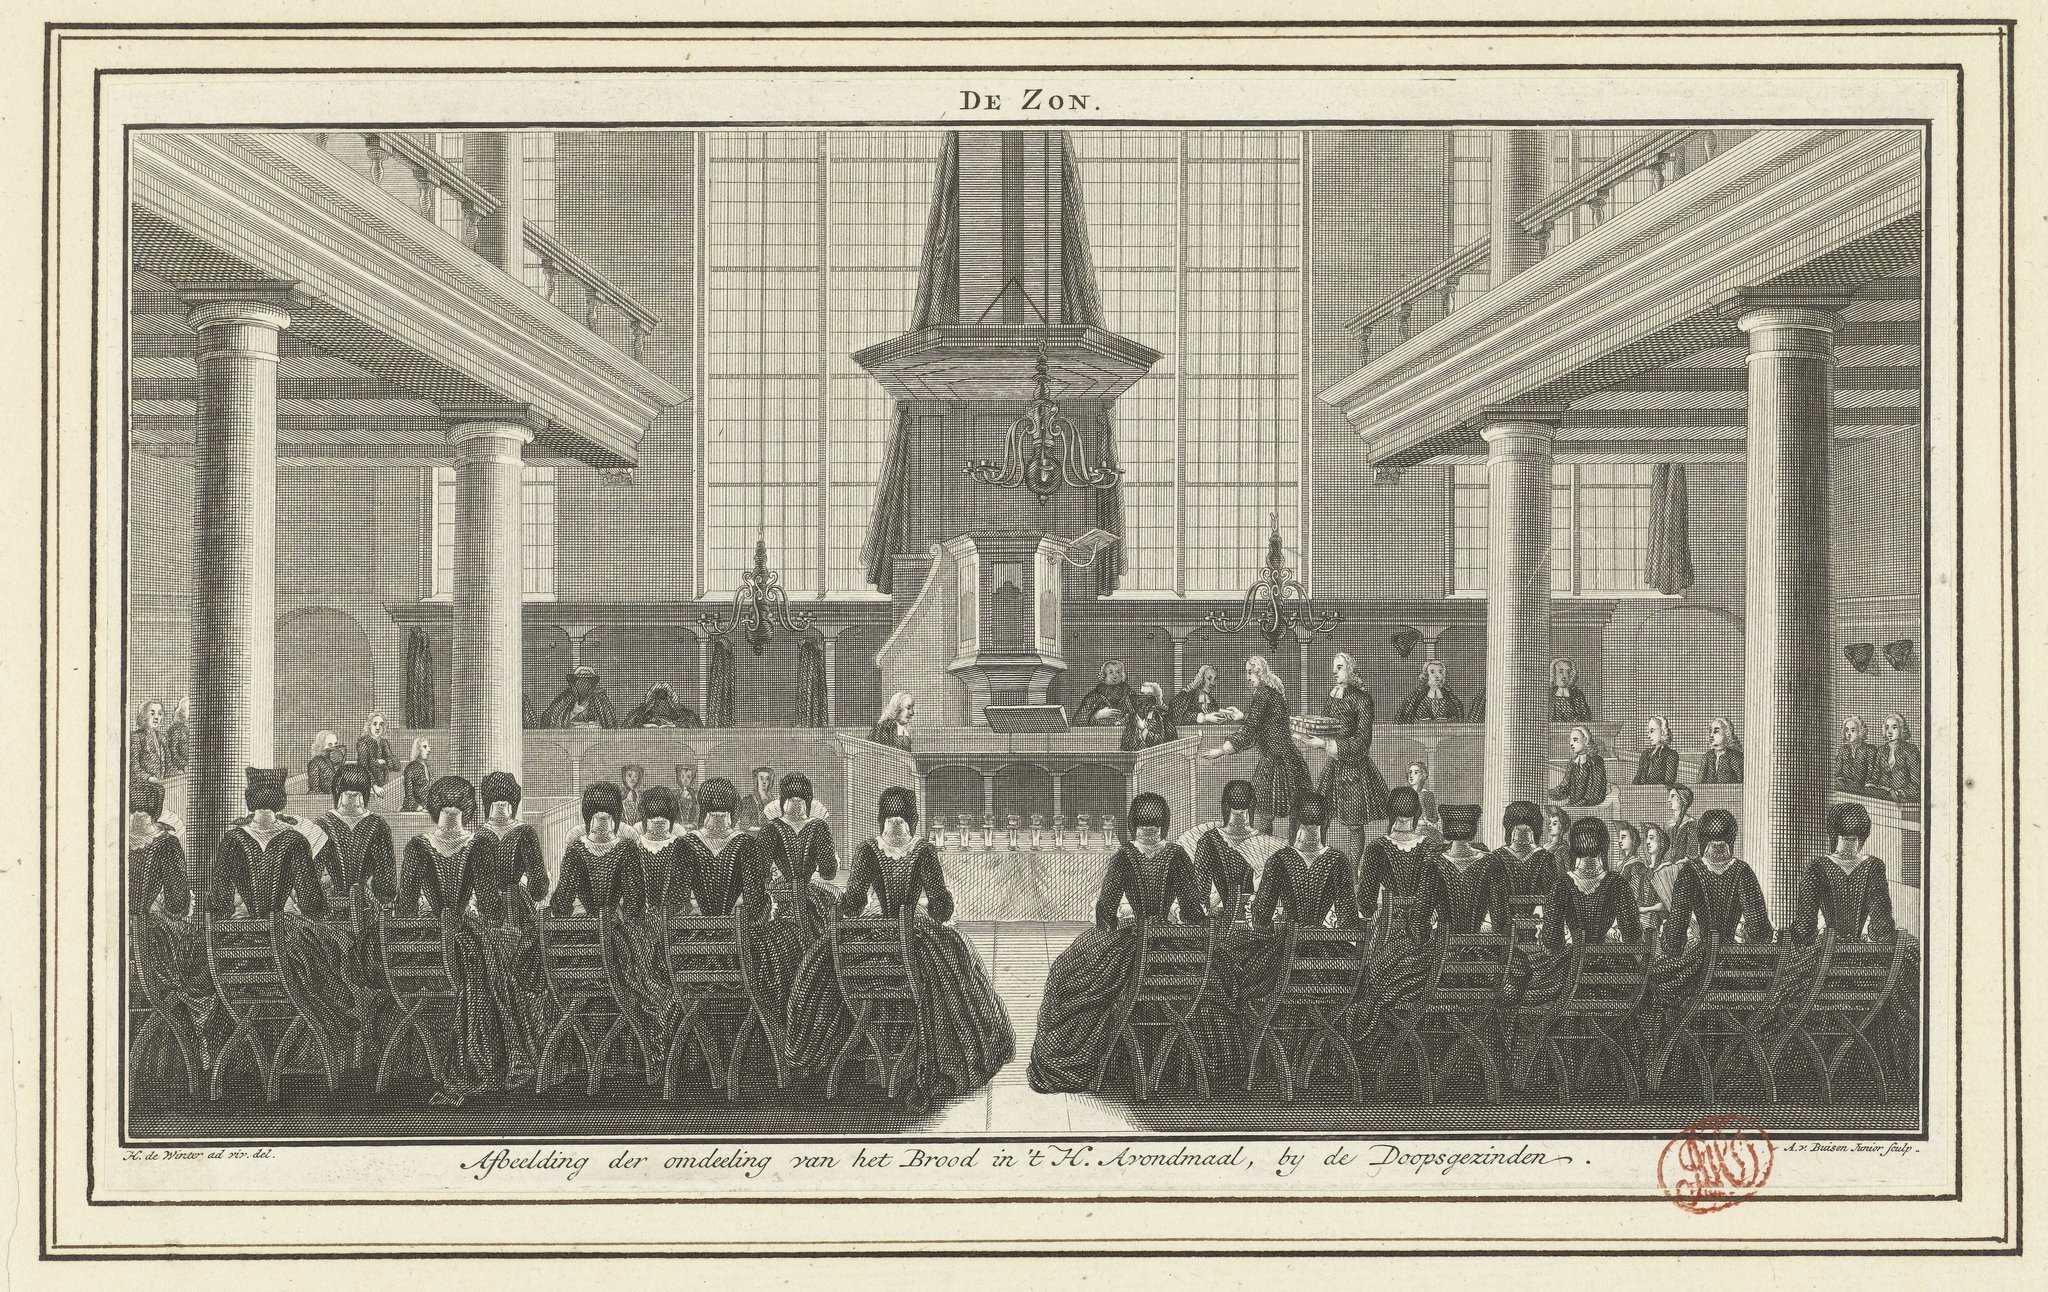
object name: print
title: De Zon / Afbeelding der omdeeling van het Brood in 't H. Avondmaal, by de Doopsgezinden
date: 1743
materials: paper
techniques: engraving, etching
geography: amsterdam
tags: protestant churches and denominations (mennonites), interior of church, holy communion ~ protestant service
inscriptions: collector's mark: Lugt 2233, collector's mark: Lugt 195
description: Delen van het brood tijdens het Heilig Avondmaal in de Doopsgezinde Kerk De Zon, de vermaning van een groep conservatievere Vlamingen, aan de Singel te Amsterdam. Deze groep had zich in 1664 afgesplitst van de Vlamingen die bijeenkwamen in de Doopsgezinde Kerk Bij 't Lam, tevens aan de Singel geleden.